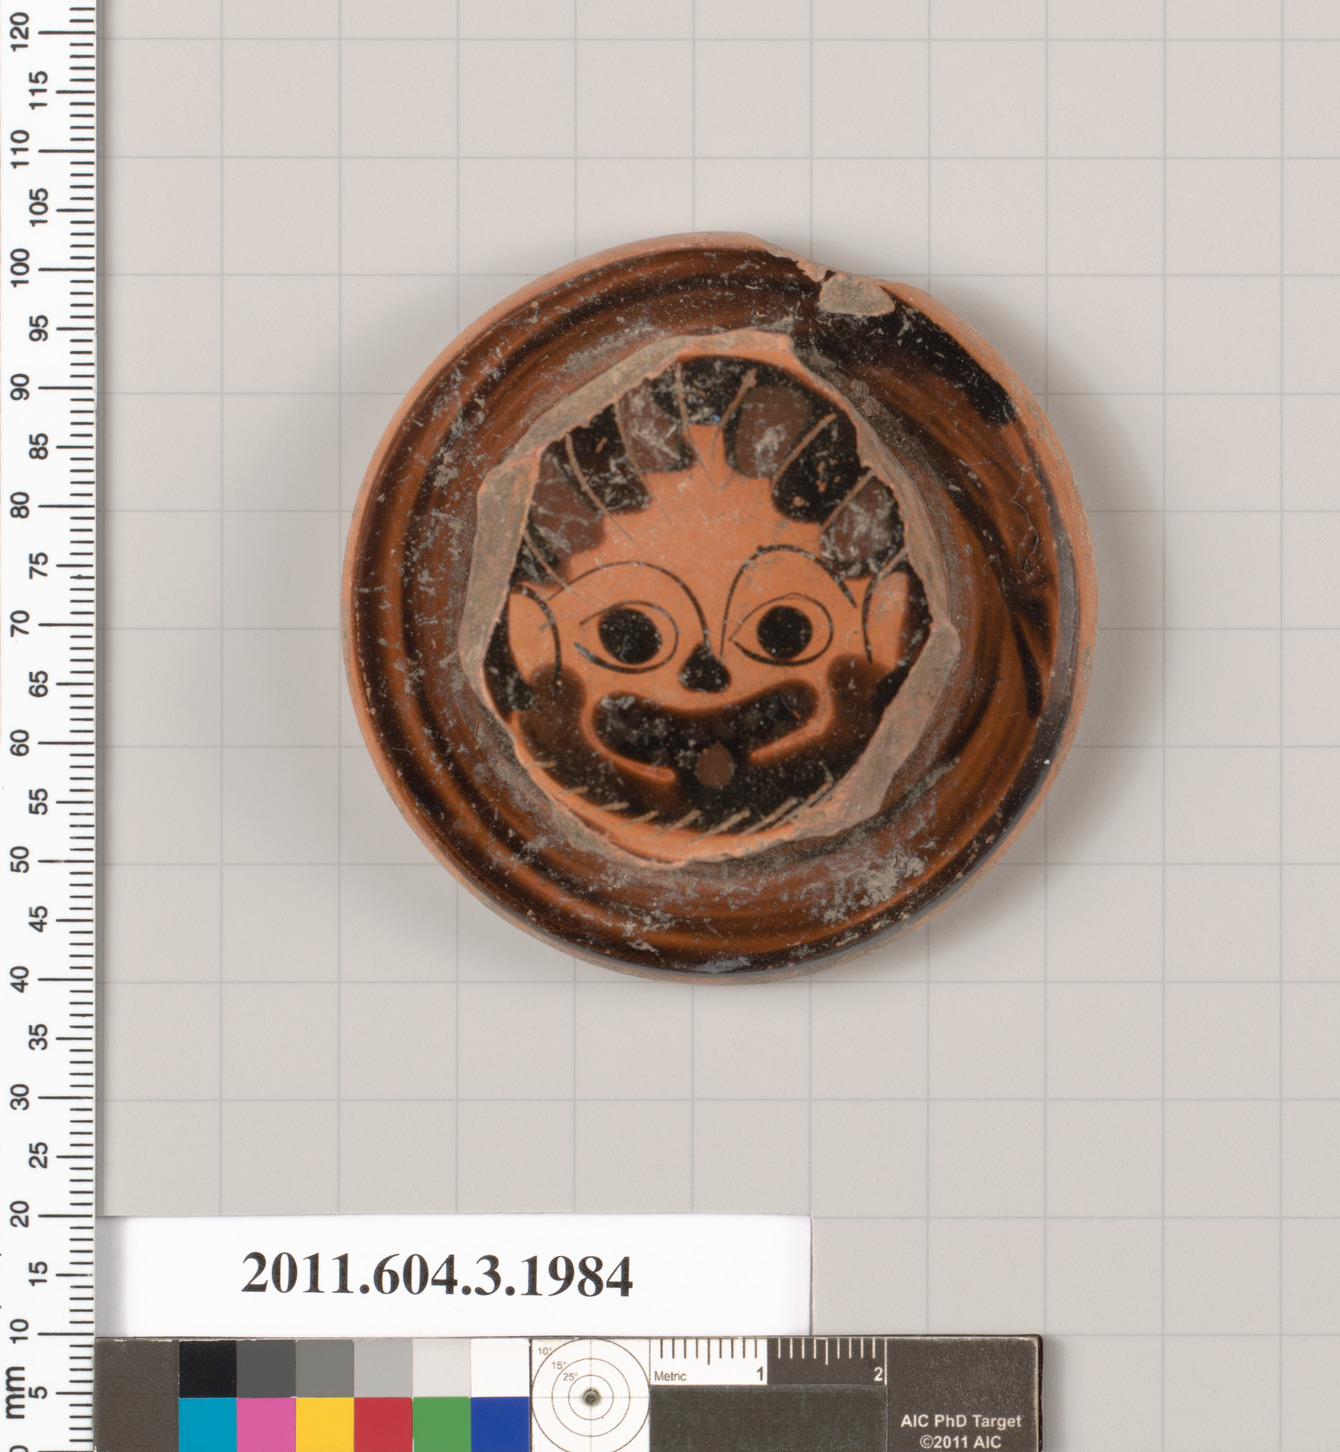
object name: kylix fragment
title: Terracotta fragment of a stemless cup (drinking cup)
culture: greek, attic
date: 550-526 BCE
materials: terracotta